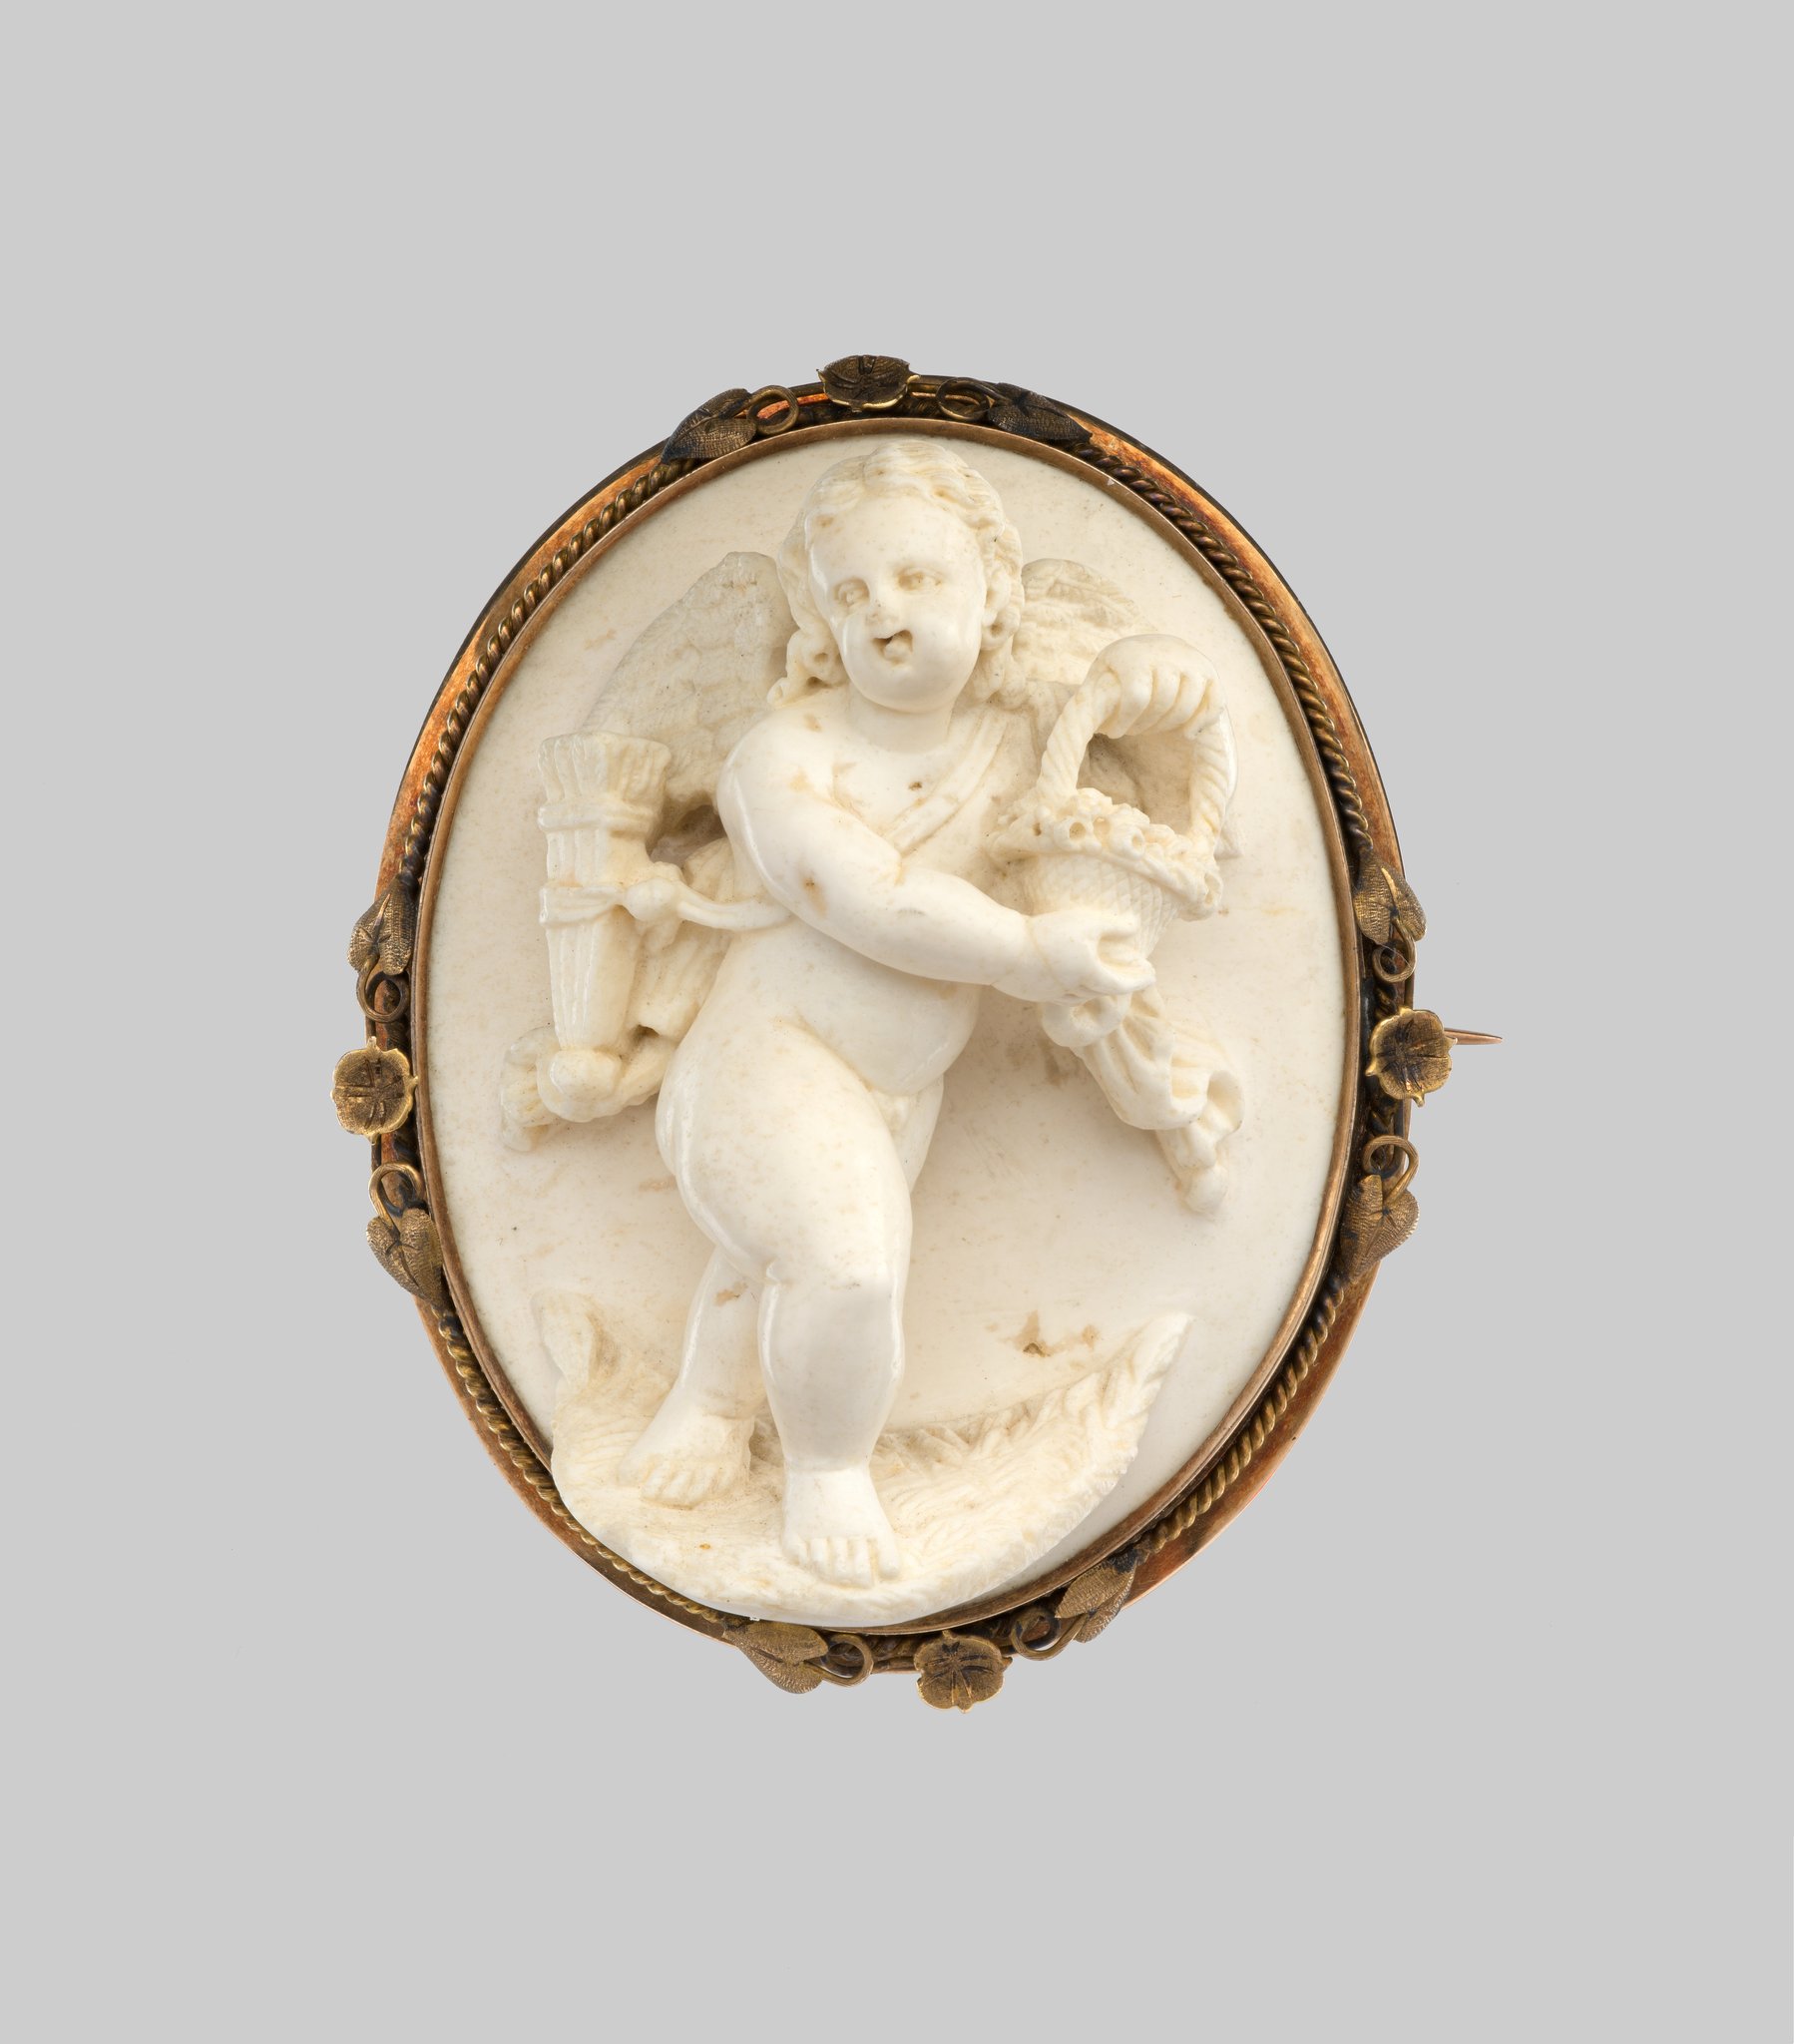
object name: brooch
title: Brooch (part of parure)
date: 1840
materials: gold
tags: cupid